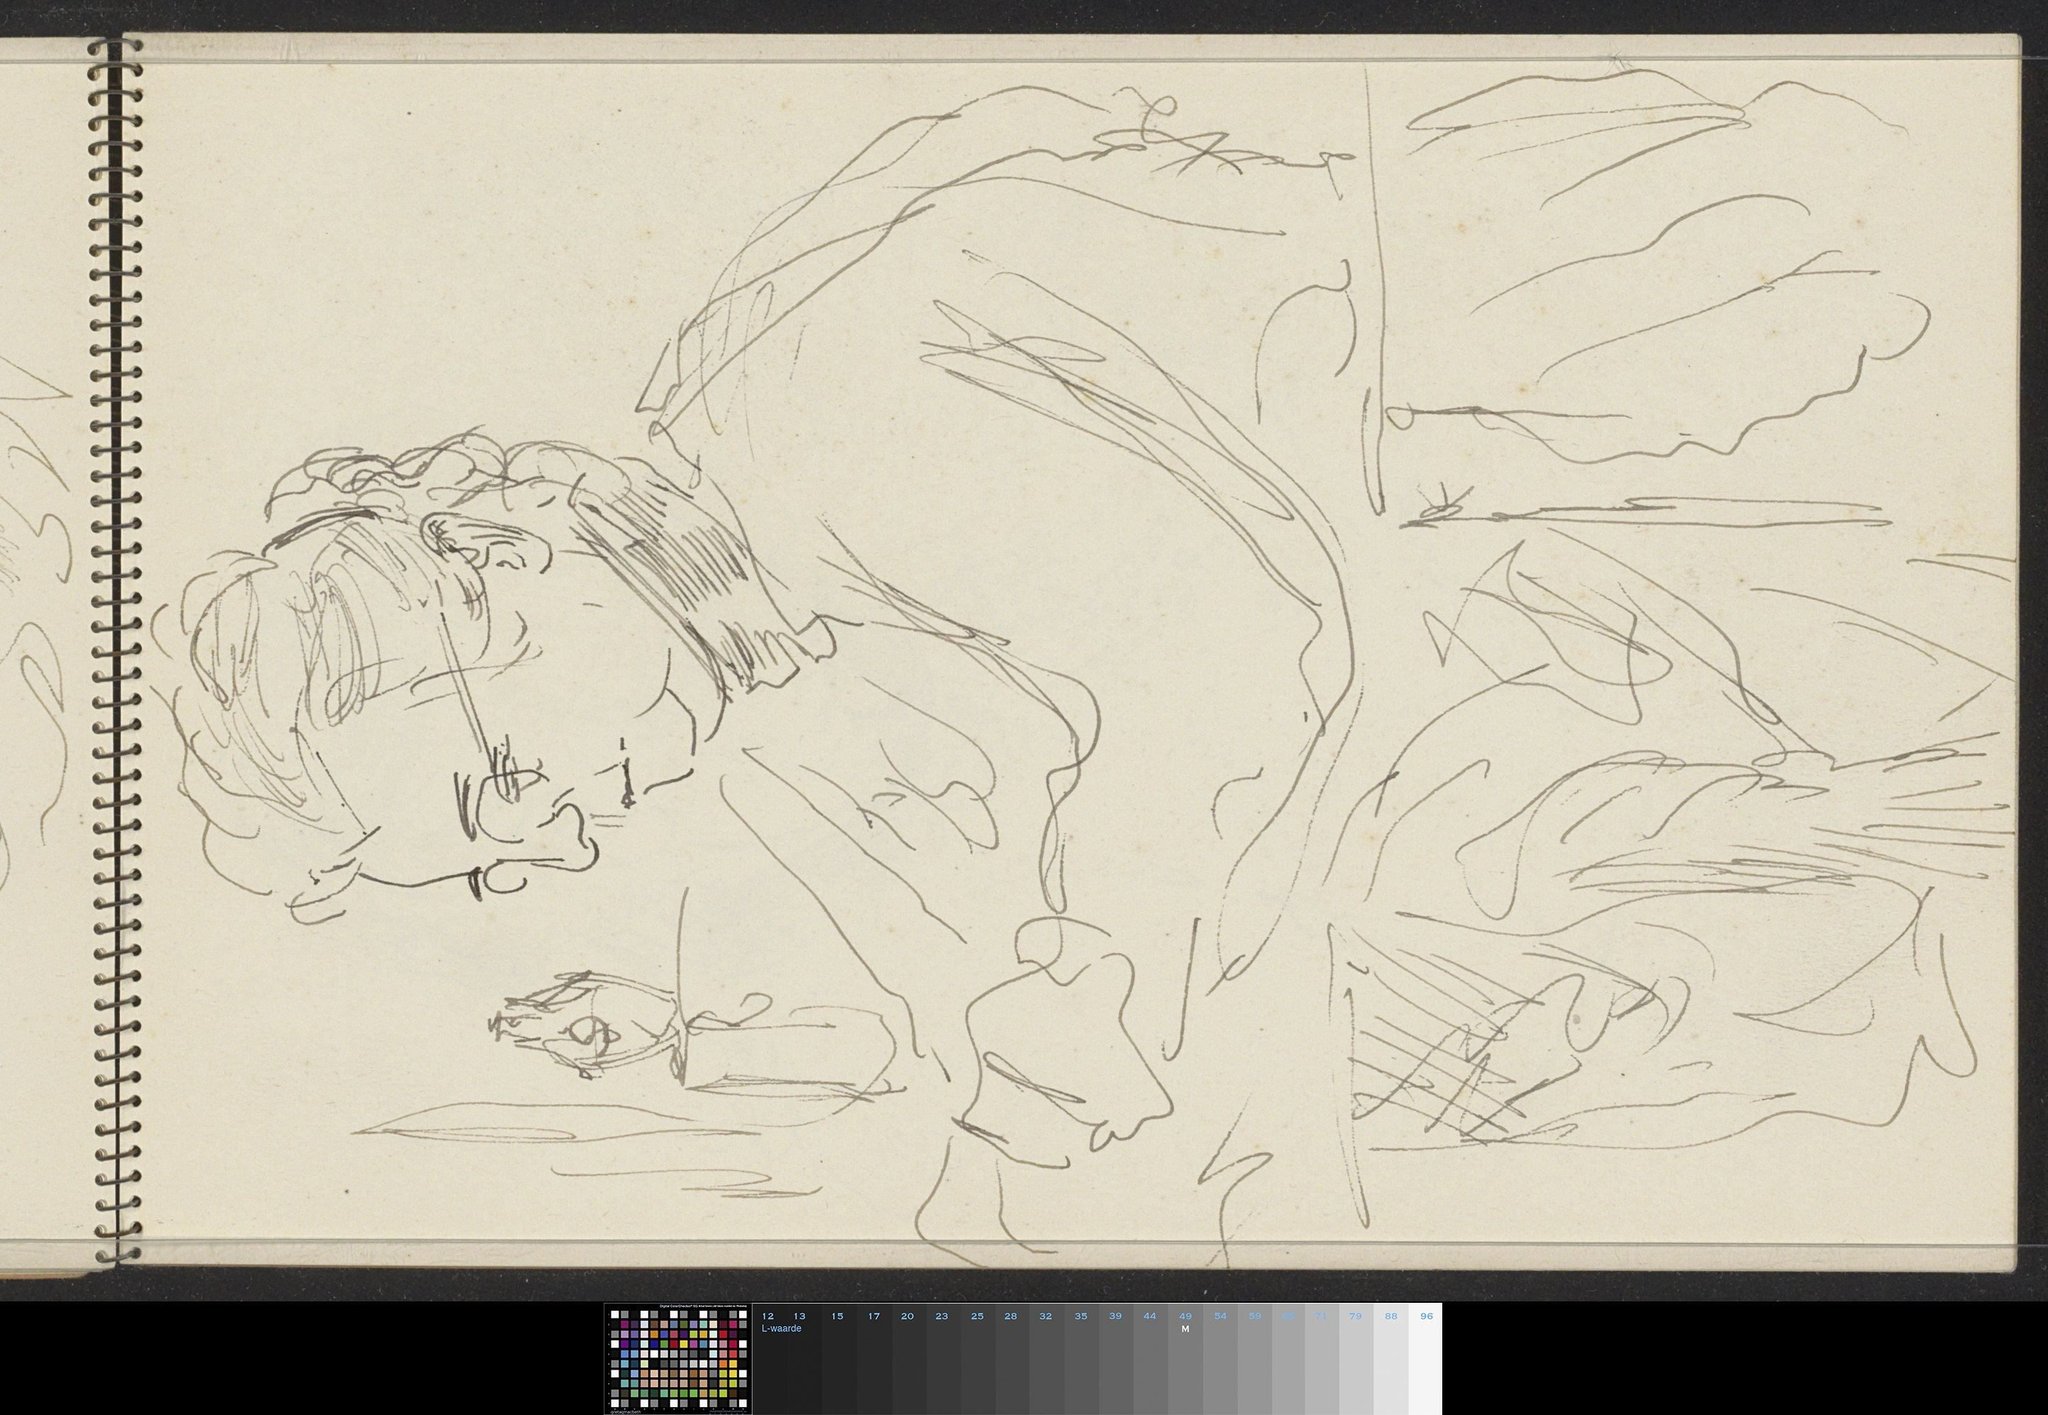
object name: sketchbook leaf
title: Zittende Joanna Lion Cachet-Cordes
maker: carel adolph lion cachet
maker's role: draughtsman, print maker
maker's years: 1864-1945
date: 1935-1940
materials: ink, paper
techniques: pen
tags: sitting figure (+ female (human being) (not to be used where -aa- is prescribed)), interior of the house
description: Mogelijk is zij aan het handwerken. Blad 12 recto uit een schetsboek met 25 bladen.